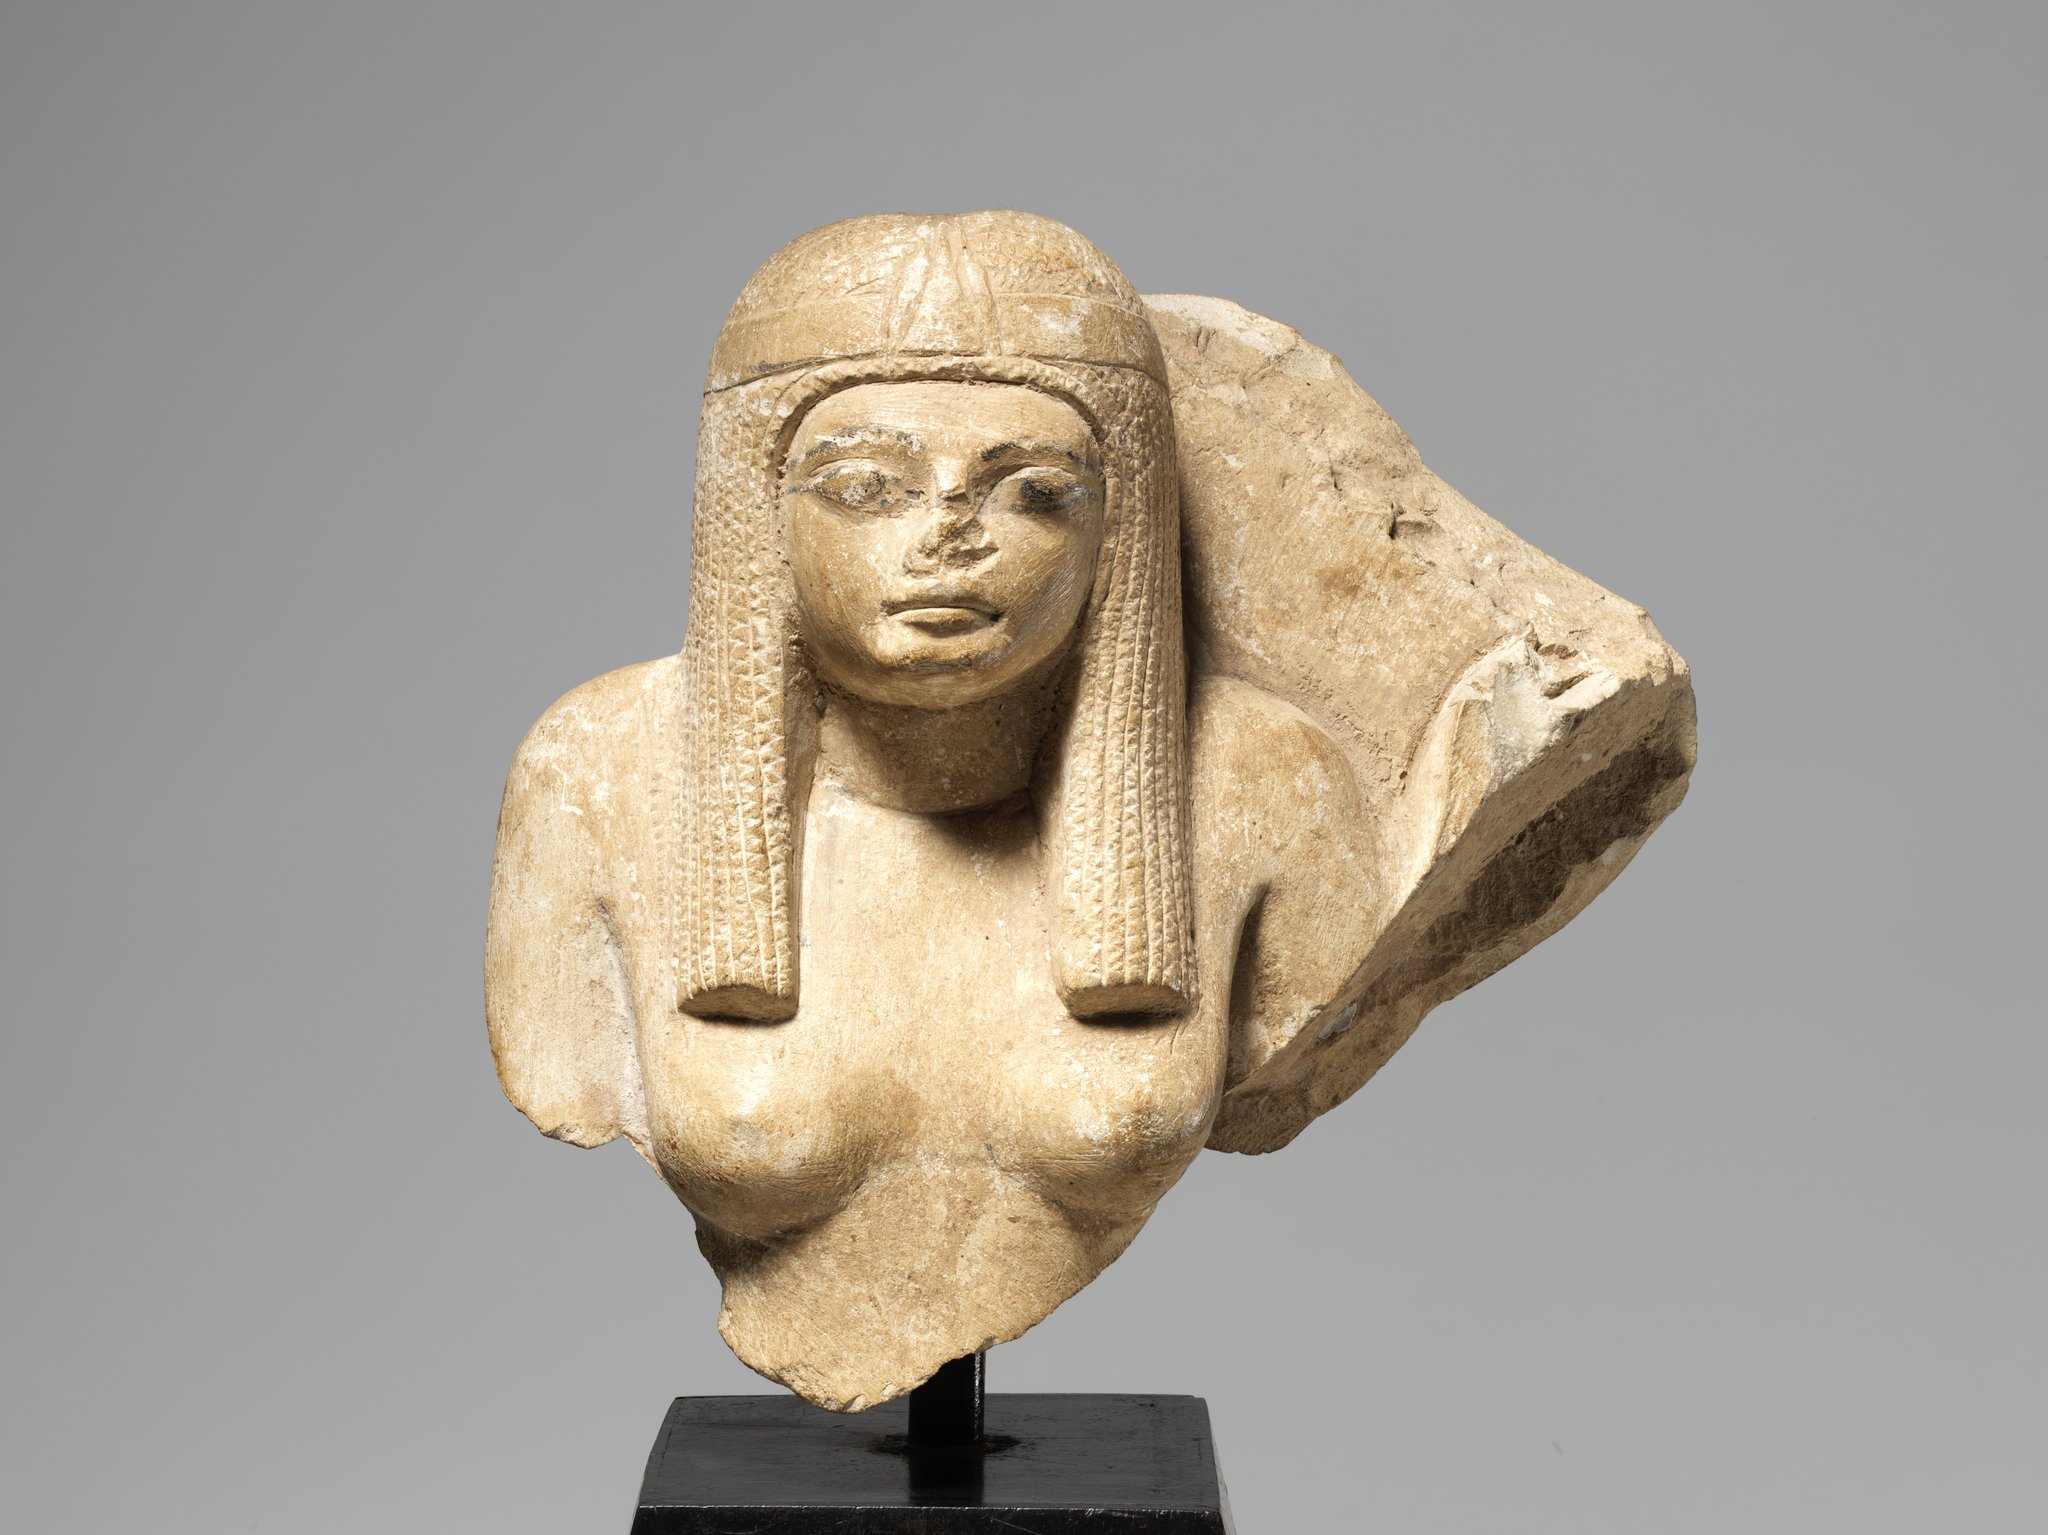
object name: female, woman, pair statue, hathor, re harakhty, wab priest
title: Upper Part of a of Woman from a Pair Statue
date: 1295-1070 BCE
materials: limestone, paint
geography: egypt